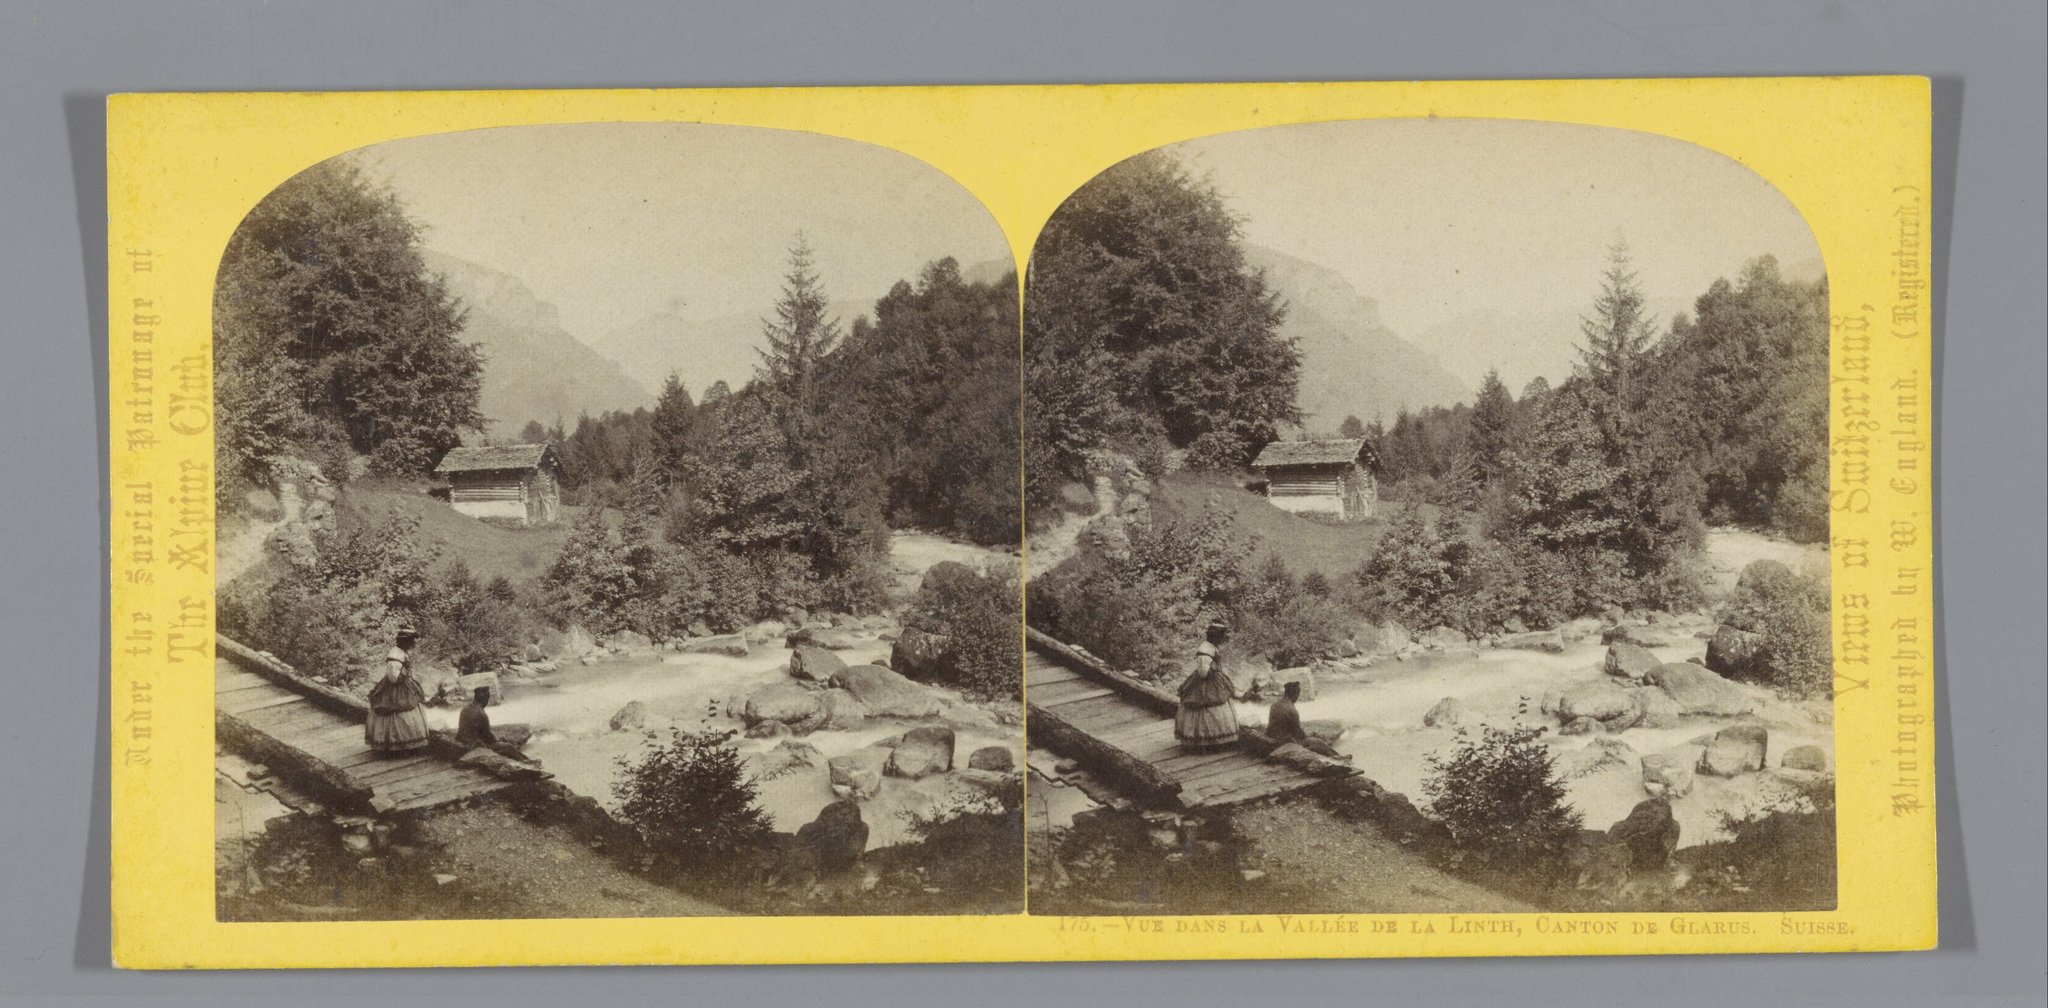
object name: stereograph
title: Vue dans la Vallée de la Linth, Canton de Glarus. Suisse.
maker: william england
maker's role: fotograaf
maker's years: 1816-1896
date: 1850-1880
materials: cardboard, photographic support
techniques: albumen print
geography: glarus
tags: river, landscape with bridge, viaduct or aqueduct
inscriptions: number: ‘175.’, inscription: ‘Views of Switzerland, photographed by W. England. (Registered) Under the Special Patronage of the Alpine Club.’